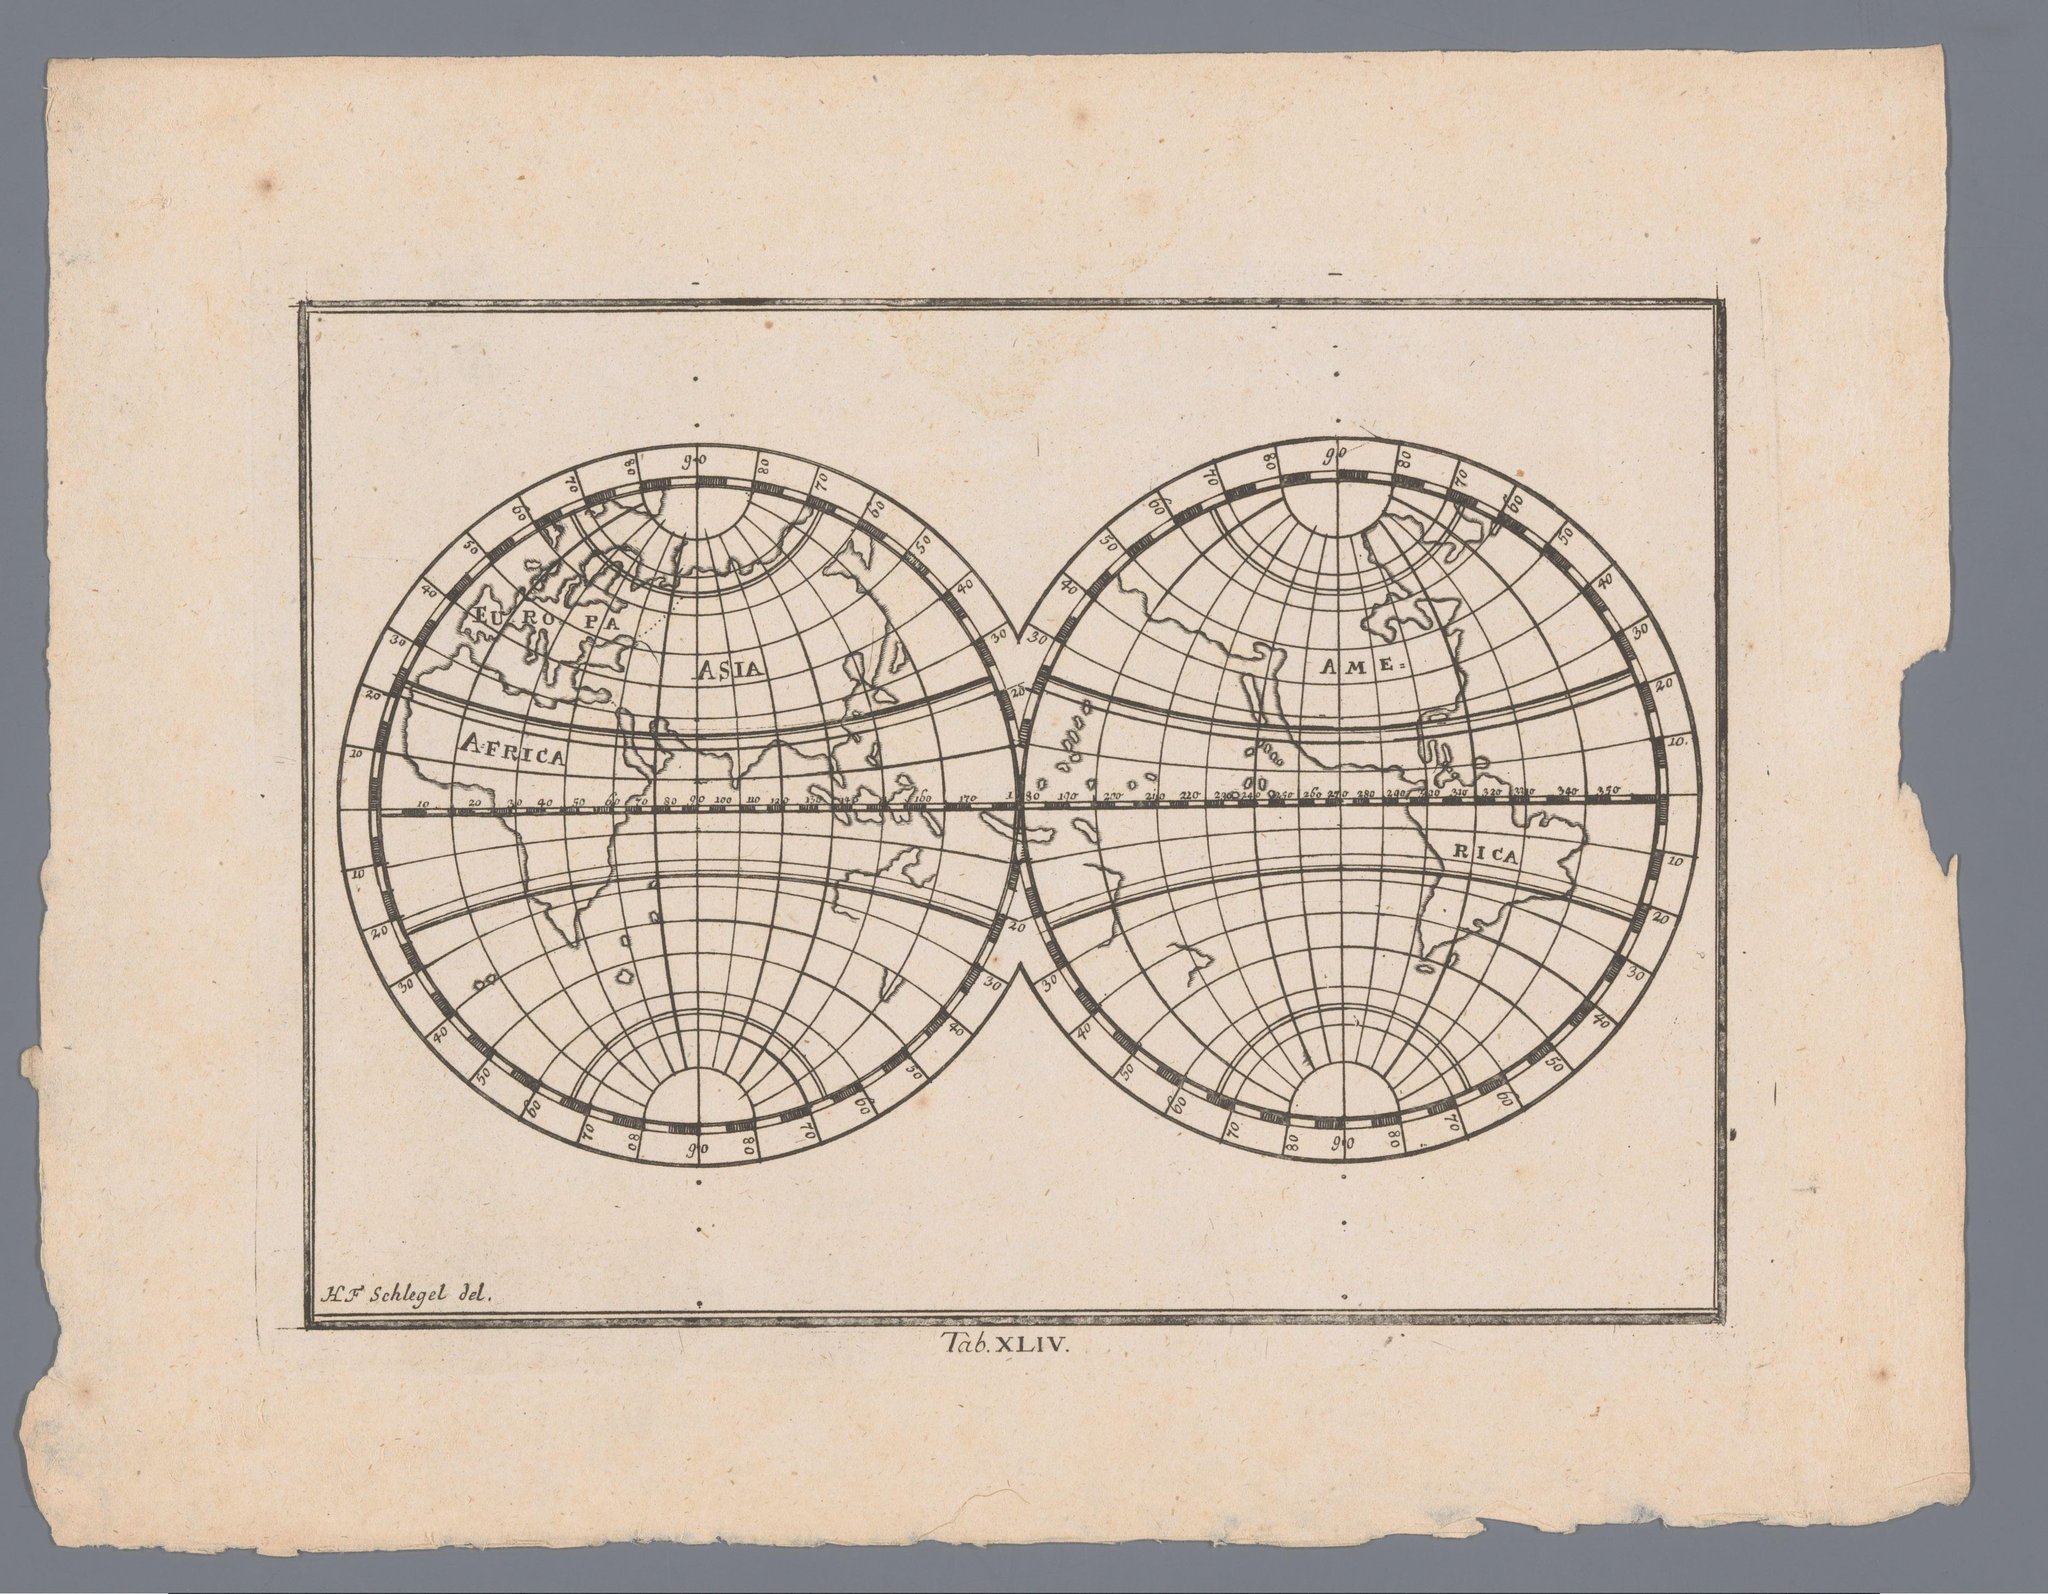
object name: print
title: Elementarische Landkarte von der Kugelfläche der Erde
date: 1774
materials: paper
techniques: etching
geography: germany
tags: map of the world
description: Prent ook gebruikt in: Basedow, Johann Bernhard. Das Basedowische Elementarwerk. Ein Vorrath der besten Erkenntnisse zum Lernen, Lehren, Wiederholen und Nachdenken. Leipzig: Siegfried Lebrecht Crucius, 1774.